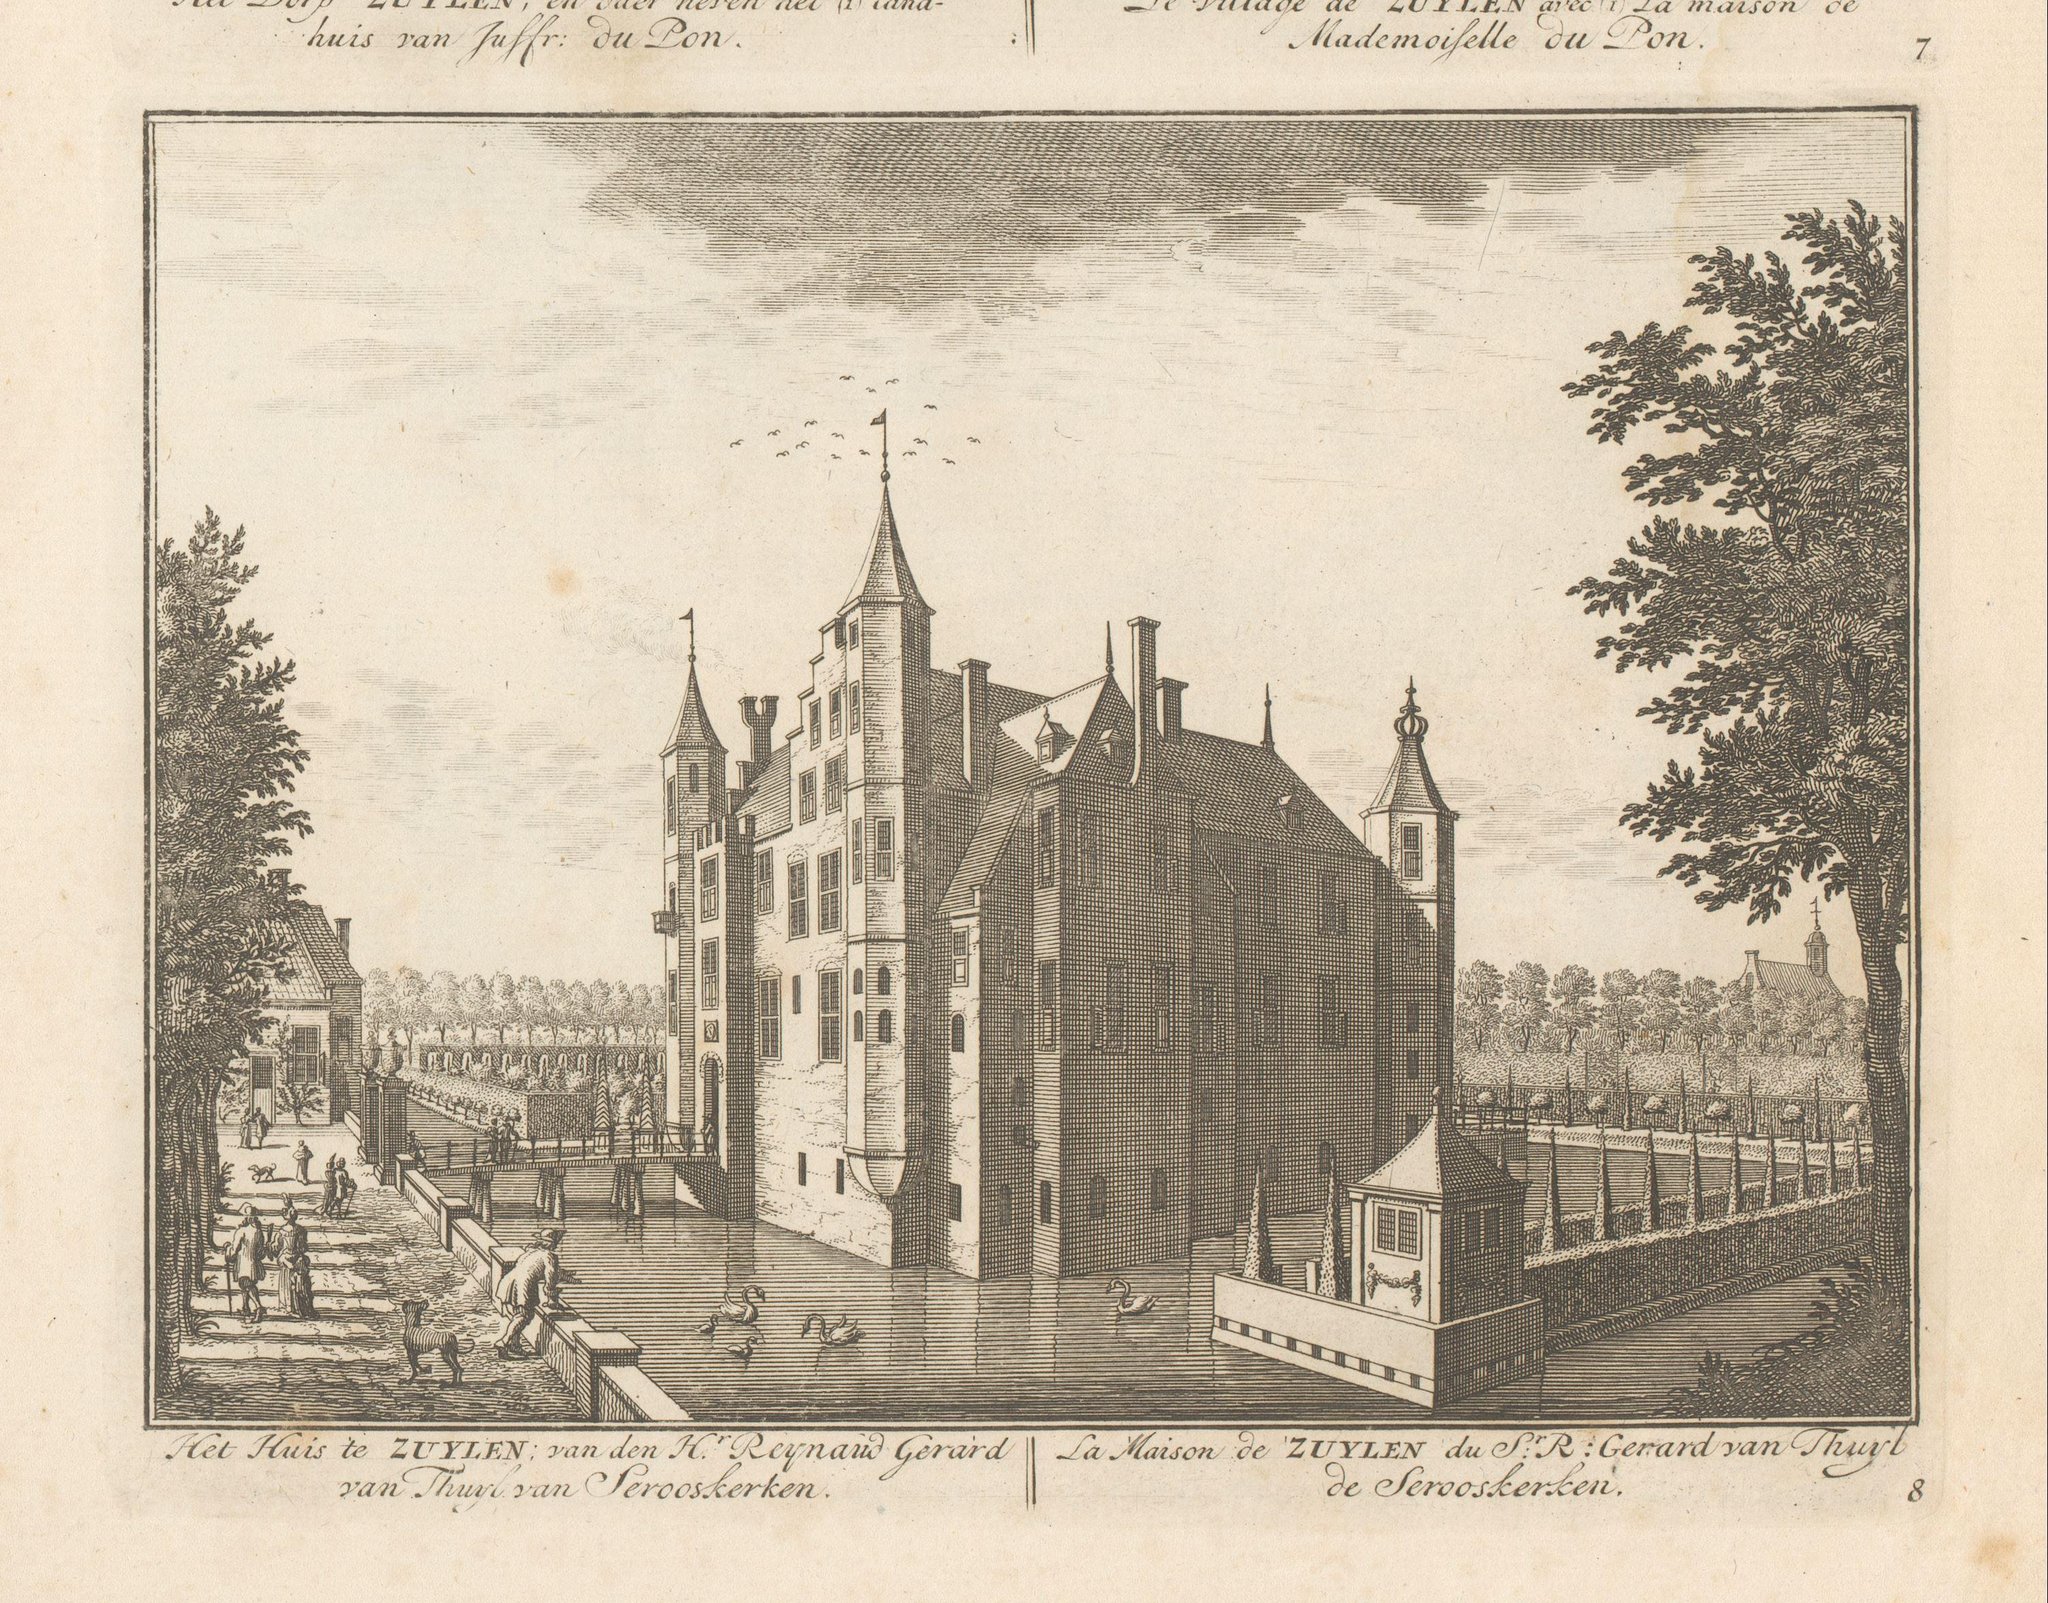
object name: book illustration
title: Gezicht op Slot Zuylen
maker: daniël stopendaal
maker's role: print maker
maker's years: 1672-1726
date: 1790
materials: paper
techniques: engraving, etching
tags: rural housing, e.g. country-house, villa, cottage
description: Prent gebruikt in: Leth, Andries de. De zegepraalende Vecht, vertoonende verscheidene gesichten van lustplaatsen, heeren huysen en dorpen, beginnende van Uitrecht en met Muyden besluytende (...). Amsterdam: Weduwe Nicolaus Visscher, 1719. Prent ook gebruikt in: Brouërius van Nidek, Matthaeus. De Vechtstroom, van Utrecht tot Muiden (...). Amsterdam: H. Gartman, W. Vermandel en J.W. Smit, 1790.